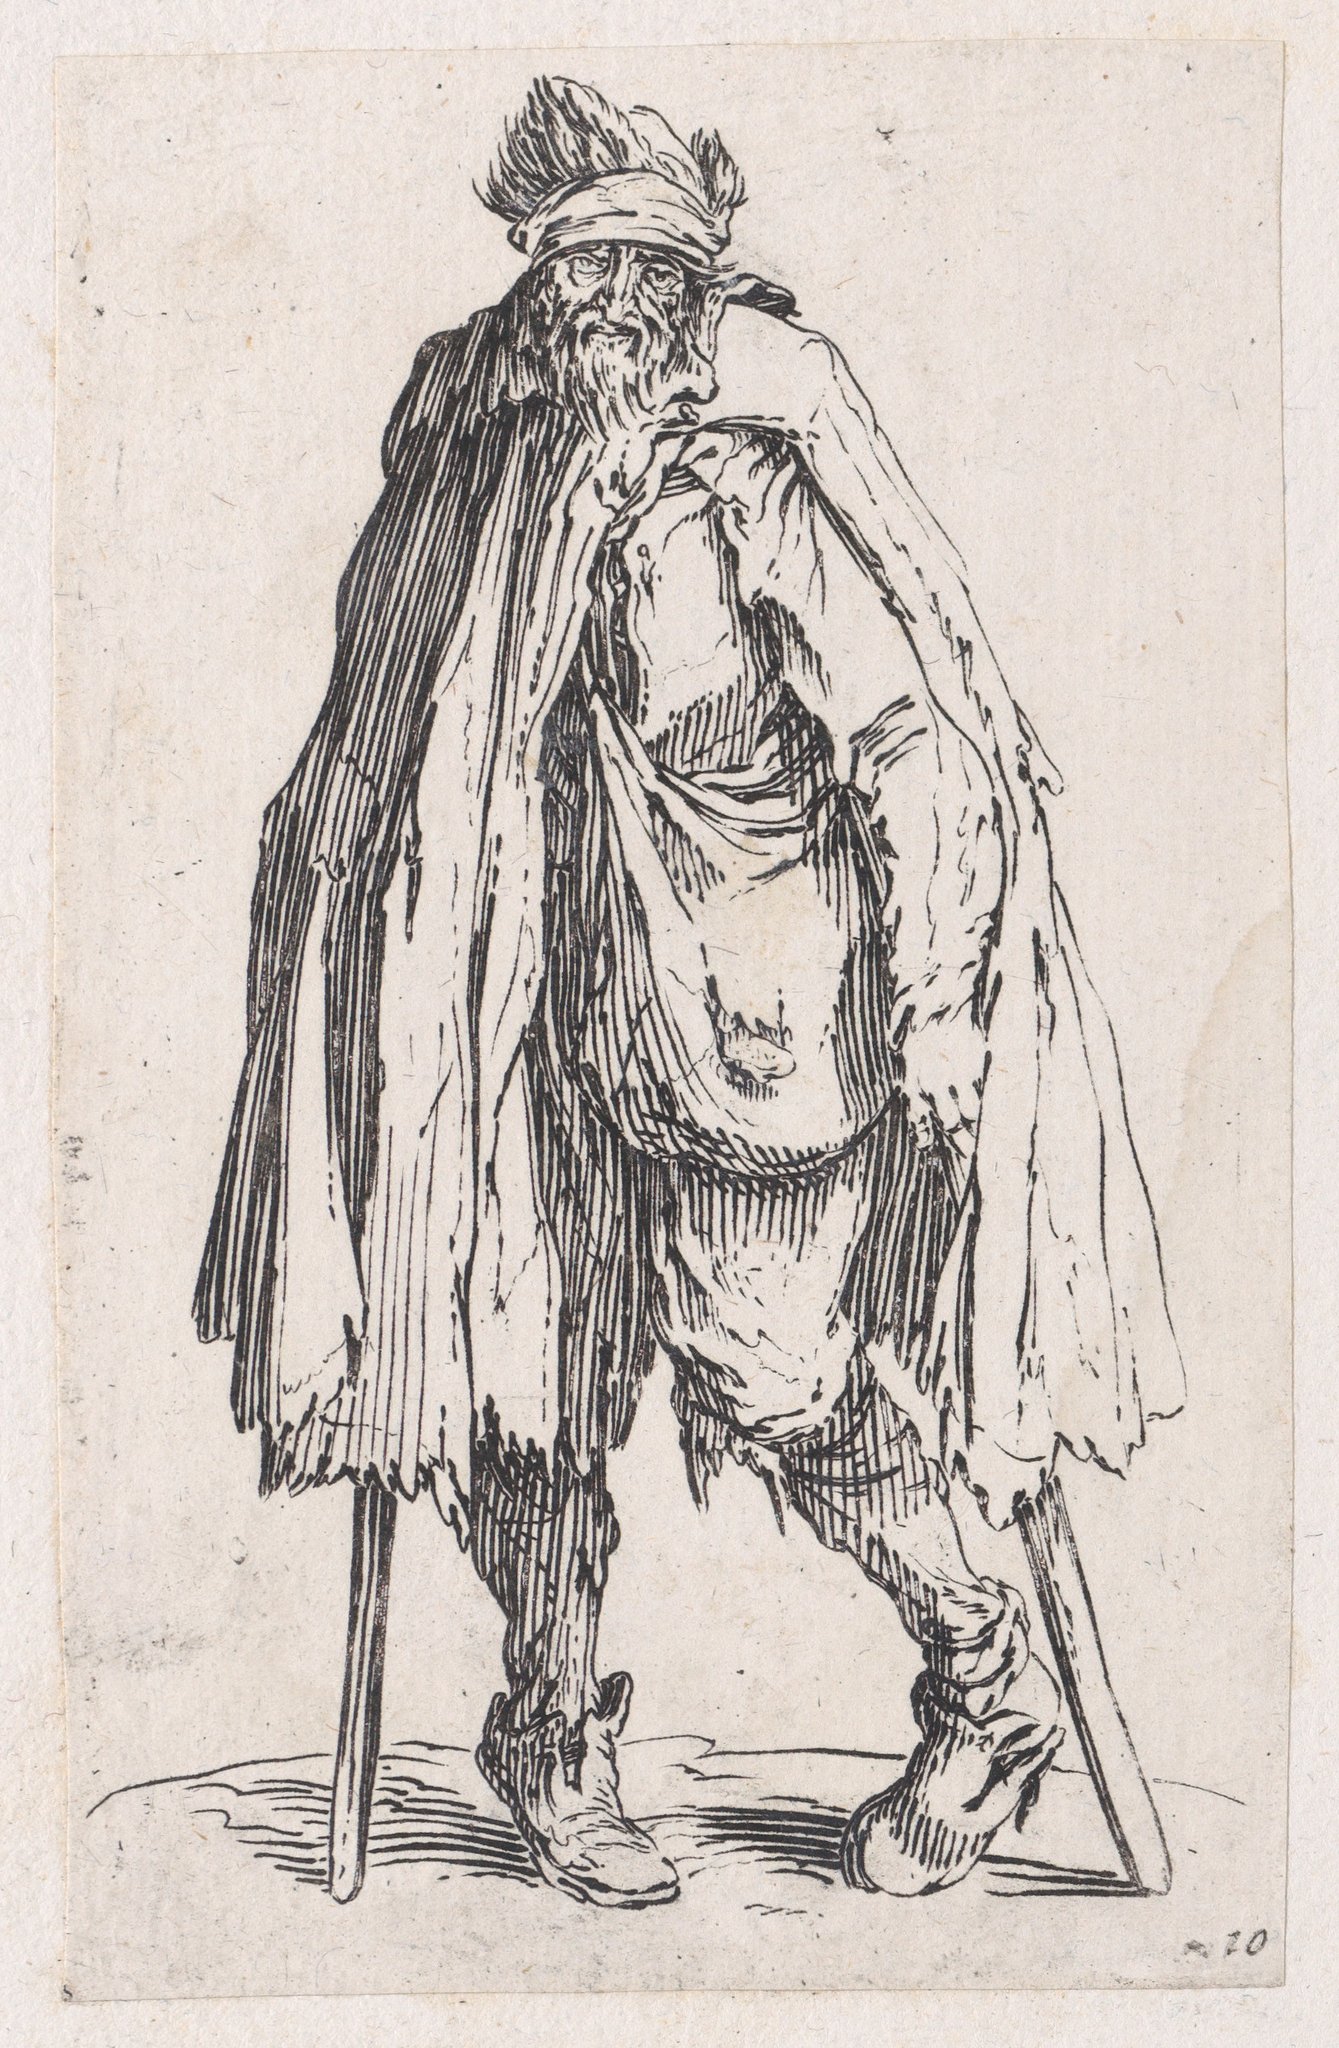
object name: print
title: Reverse Copy of Le Mendiant aux Béquilles et la Besace (The Beggar with the Crutches and the Pouch), from Les Gueux suite appelée aussi Les Mendiants, Les Baroni, ou Les Barons (The Beggars, also called the Barons)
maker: Anonymous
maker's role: artist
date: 1601-1700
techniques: etching